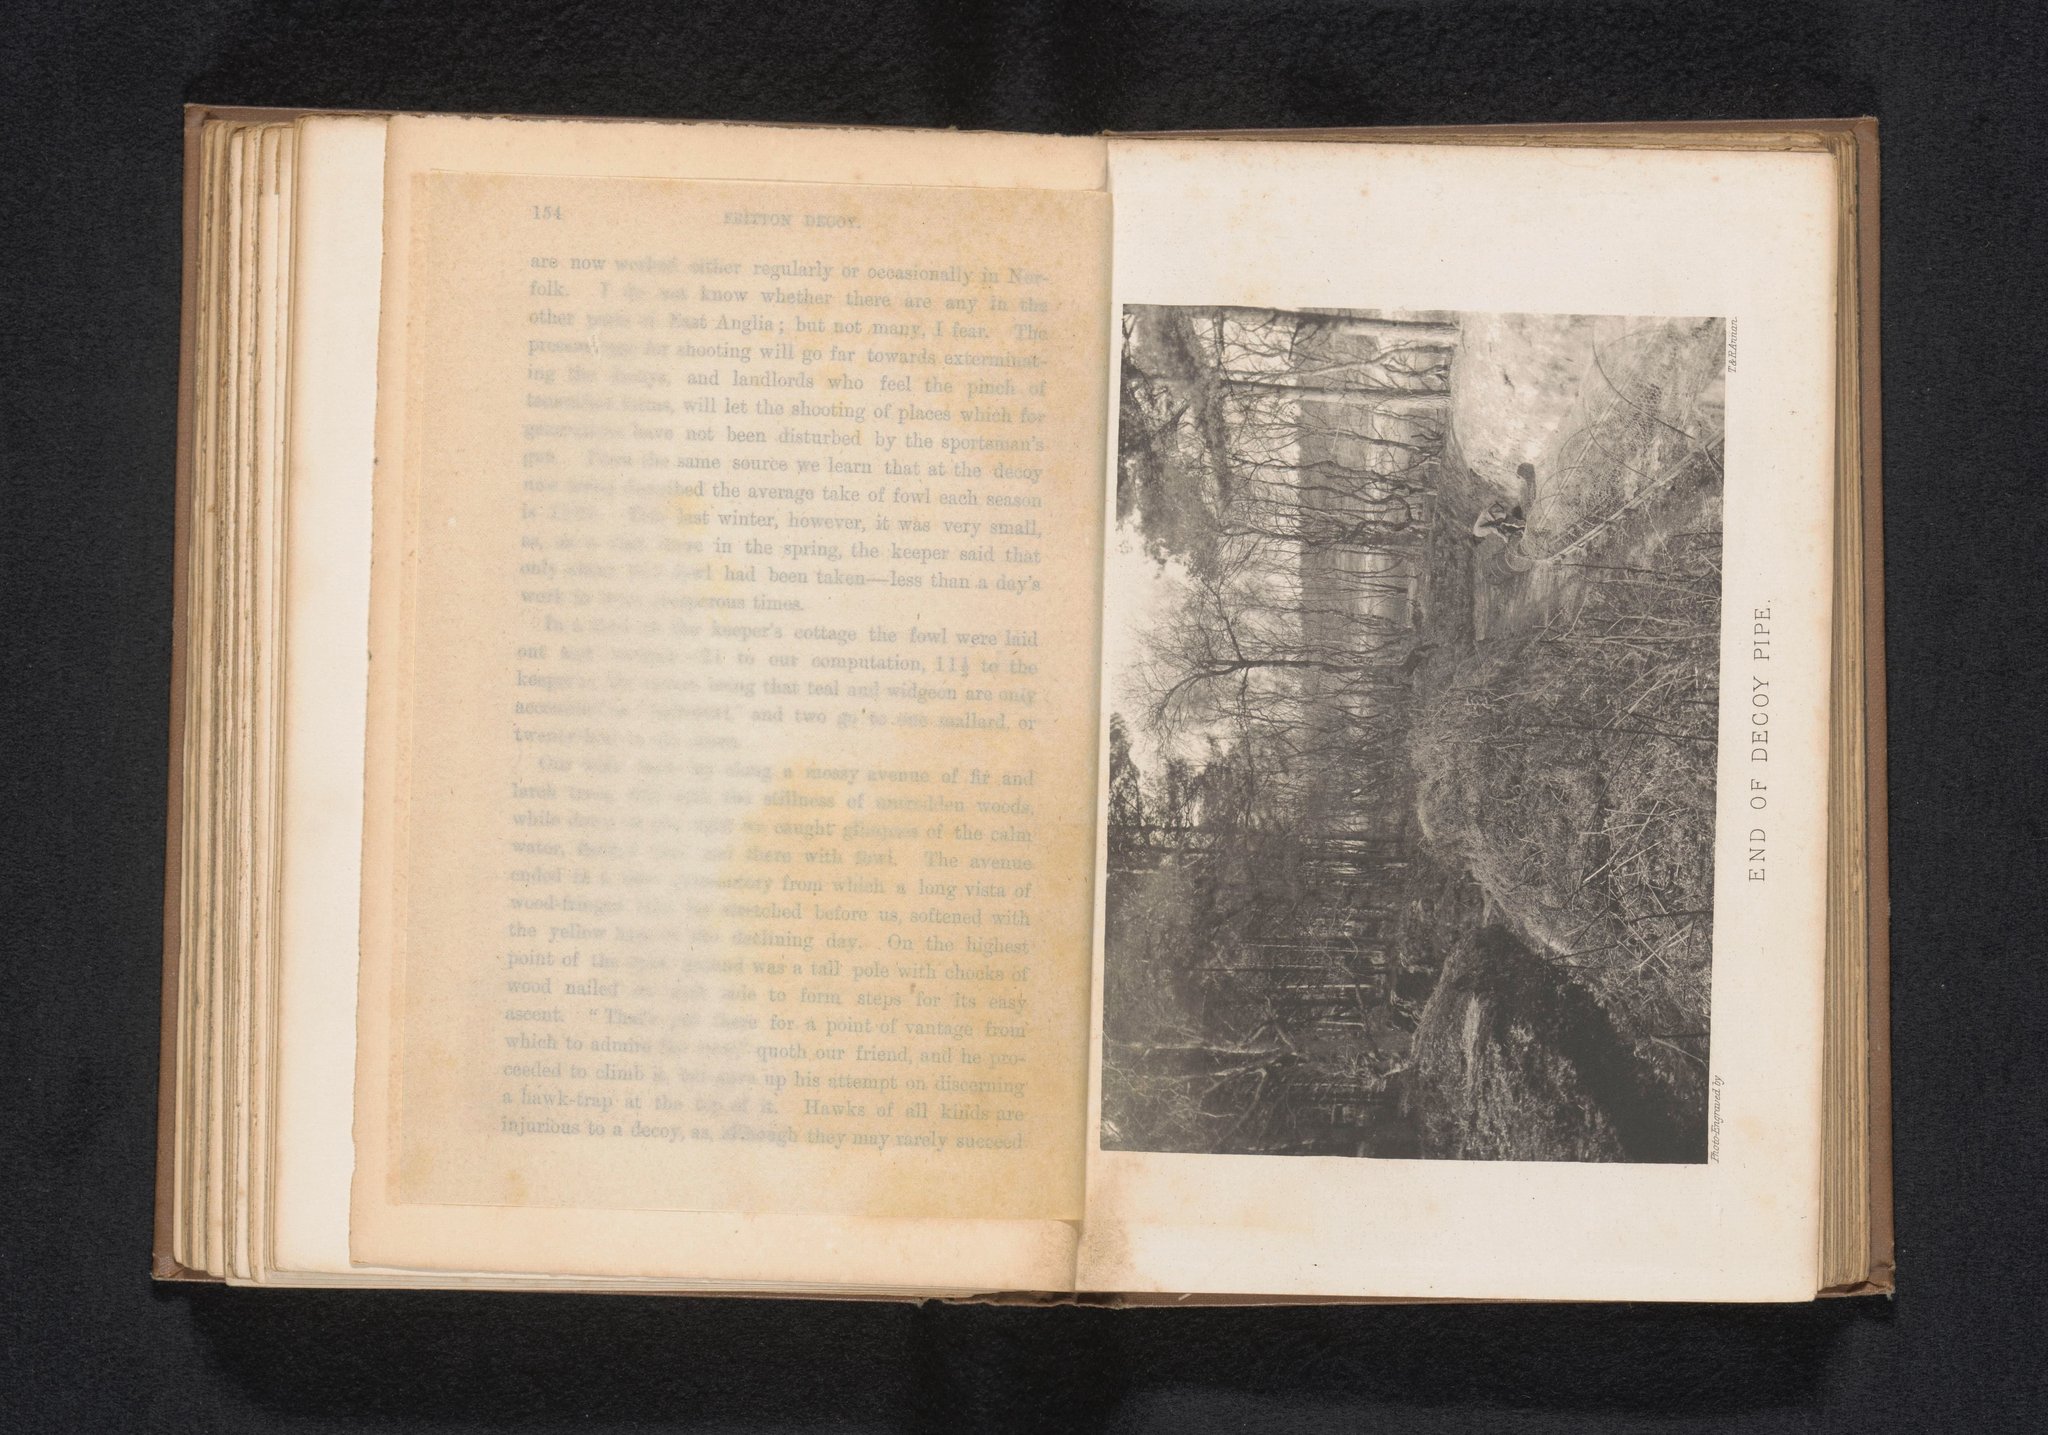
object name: page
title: End of decoy pipe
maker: george christopher davies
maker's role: fotograaf, geoloog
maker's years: 1849-1922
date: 1878-1883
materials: paper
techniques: photoaquatint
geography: fritton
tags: duck decoy